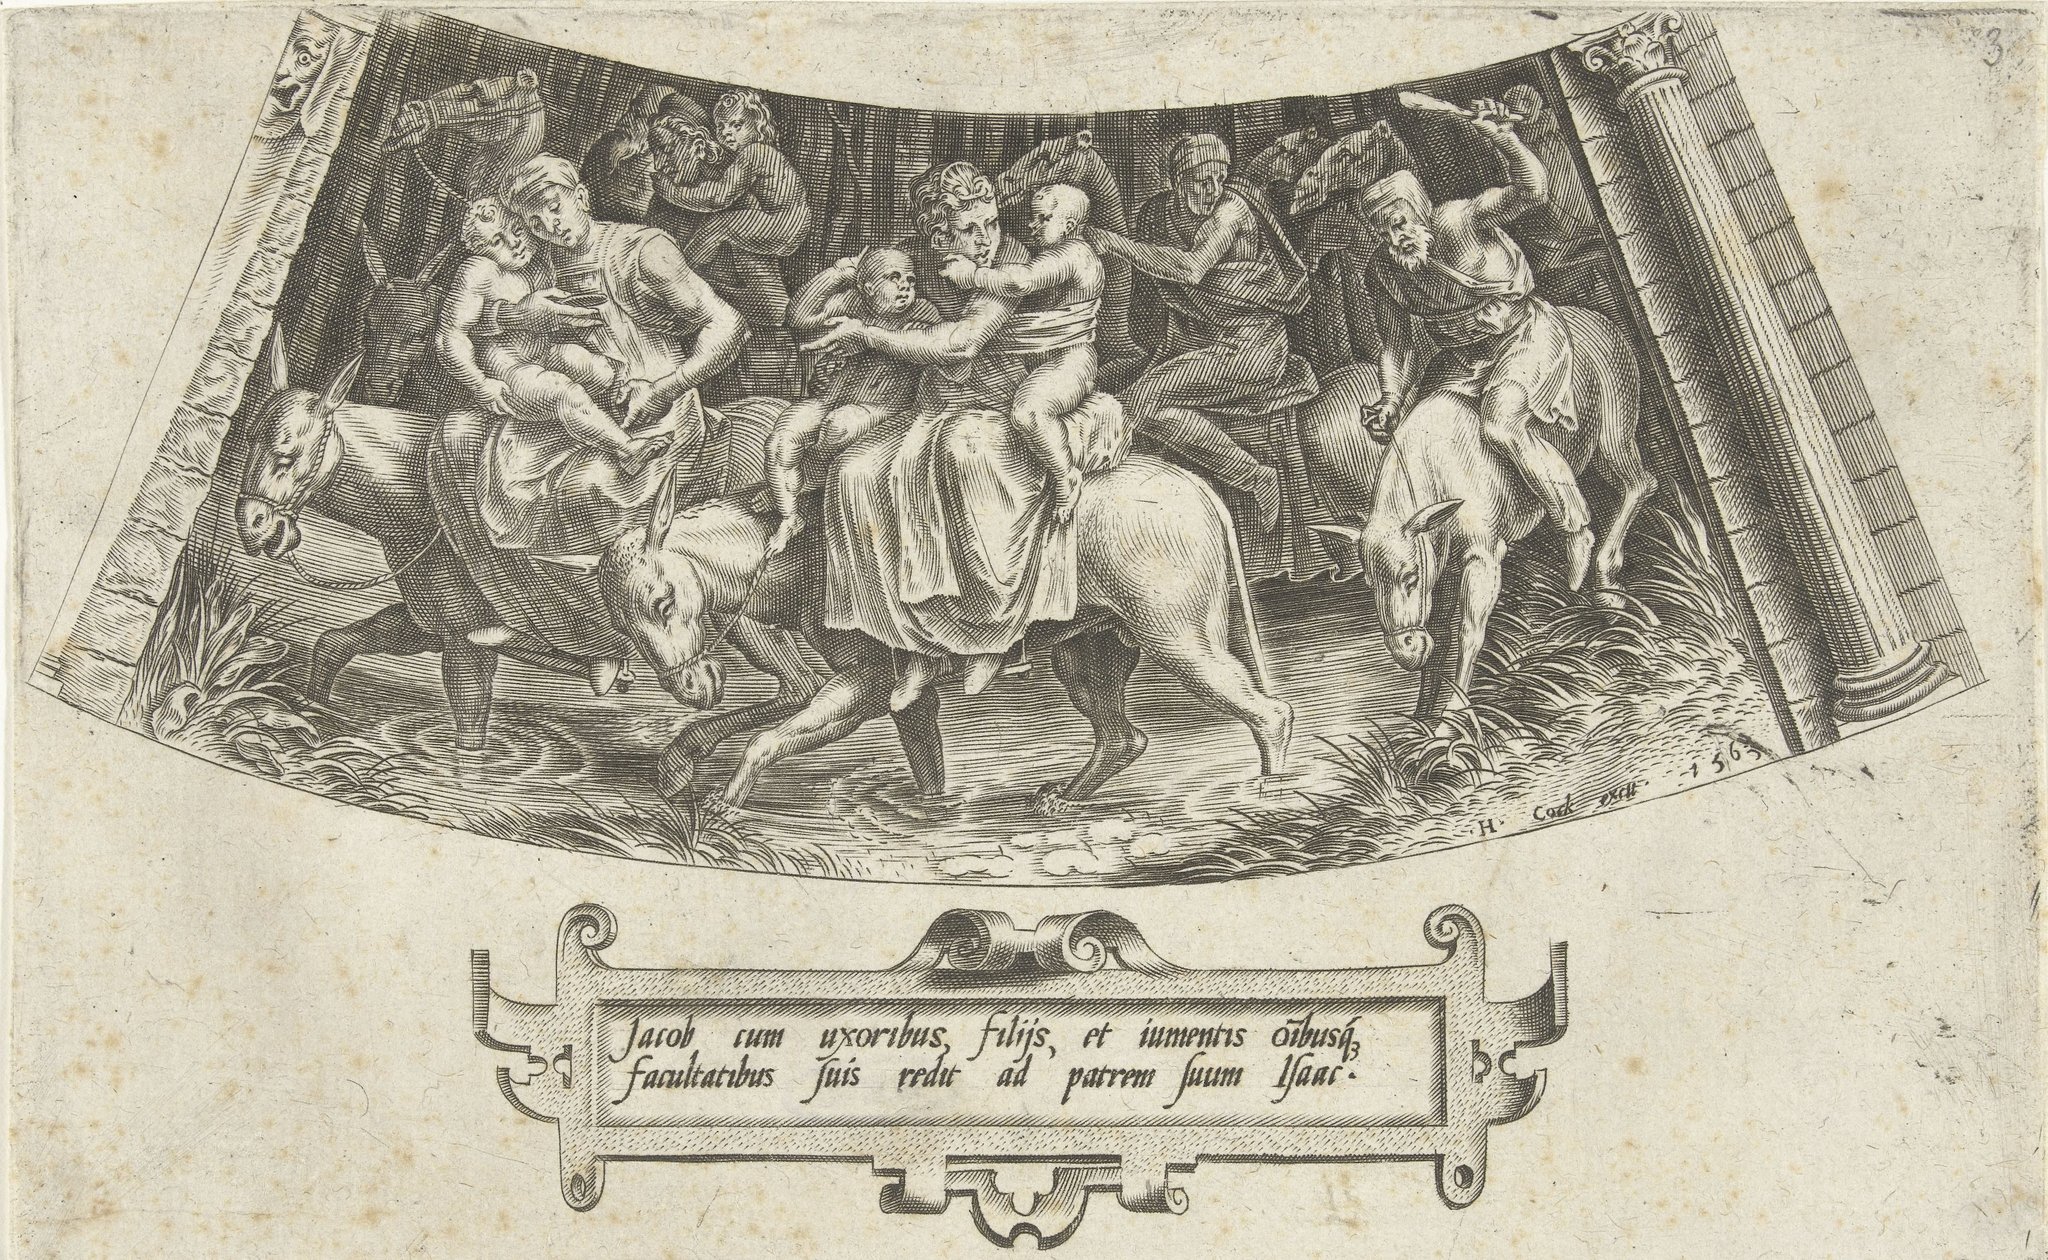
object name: print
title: De geschiedenis van Jacob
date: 1563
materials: paper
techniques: engraving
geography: antwerp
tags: ornament ~ cartouche, jacob's journey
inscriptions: collector's mark: Lugt 2228, caption: ‘Jacob cum uxoribus, filijs, et iumentis o[p]ibusque / facultatibus suis redit ad patrem suum Isaac.’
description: Ornament voor schotelrand. Jakob en zijn familie rijdend op ezels, terugkerend naar Kanaän. Met tekst in Latijn in cartouche onder de voorstelling.